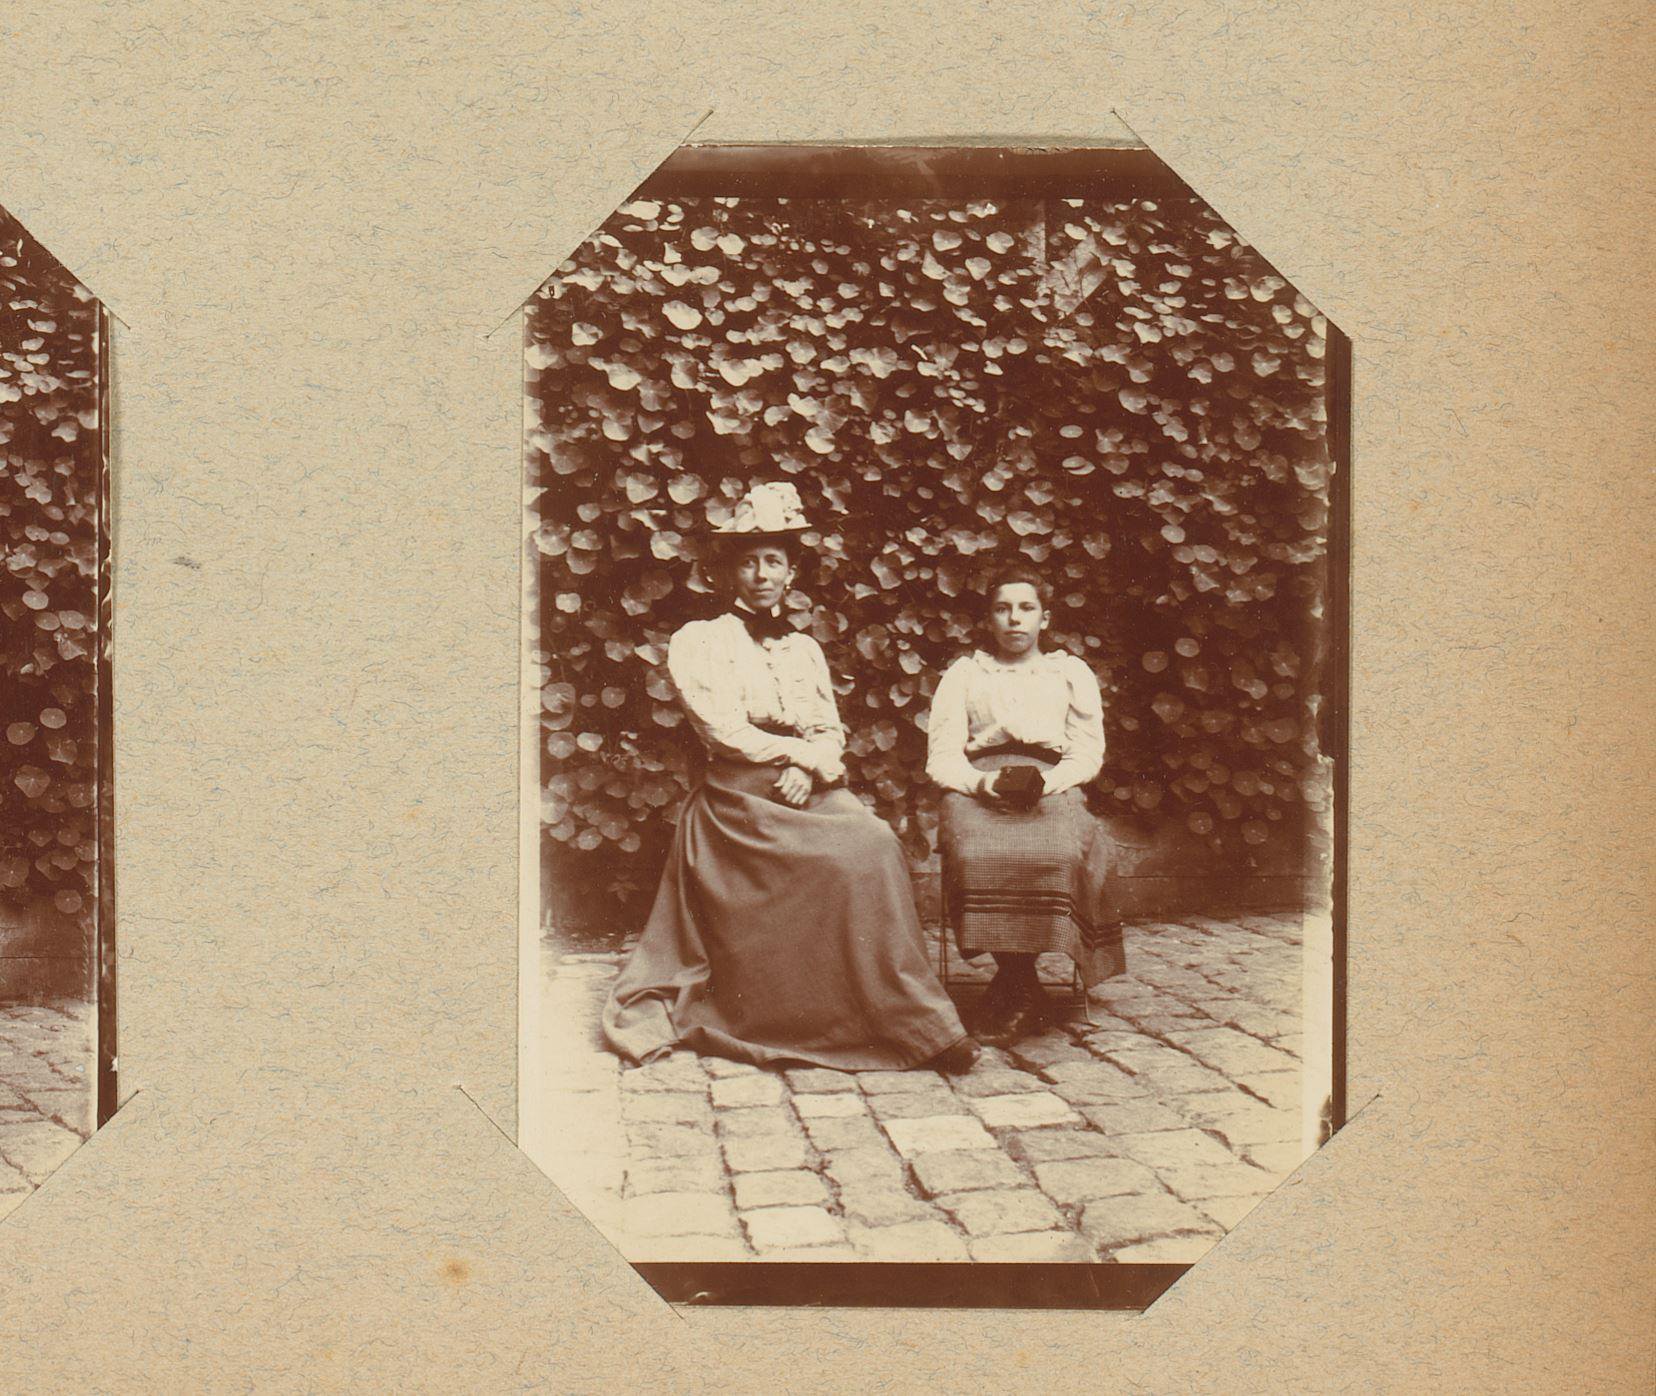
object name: album leaf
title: Portret van twee vrouwen bij een muur met klimop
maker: Anonymous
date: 1897-1900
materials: paper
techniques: gelatin silver print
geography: france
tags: adult woman, garden, historical persons, plants and herbs: ivy, france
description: Over de foto is een ander negatief afgedrukt van een voorstelling van bomen.